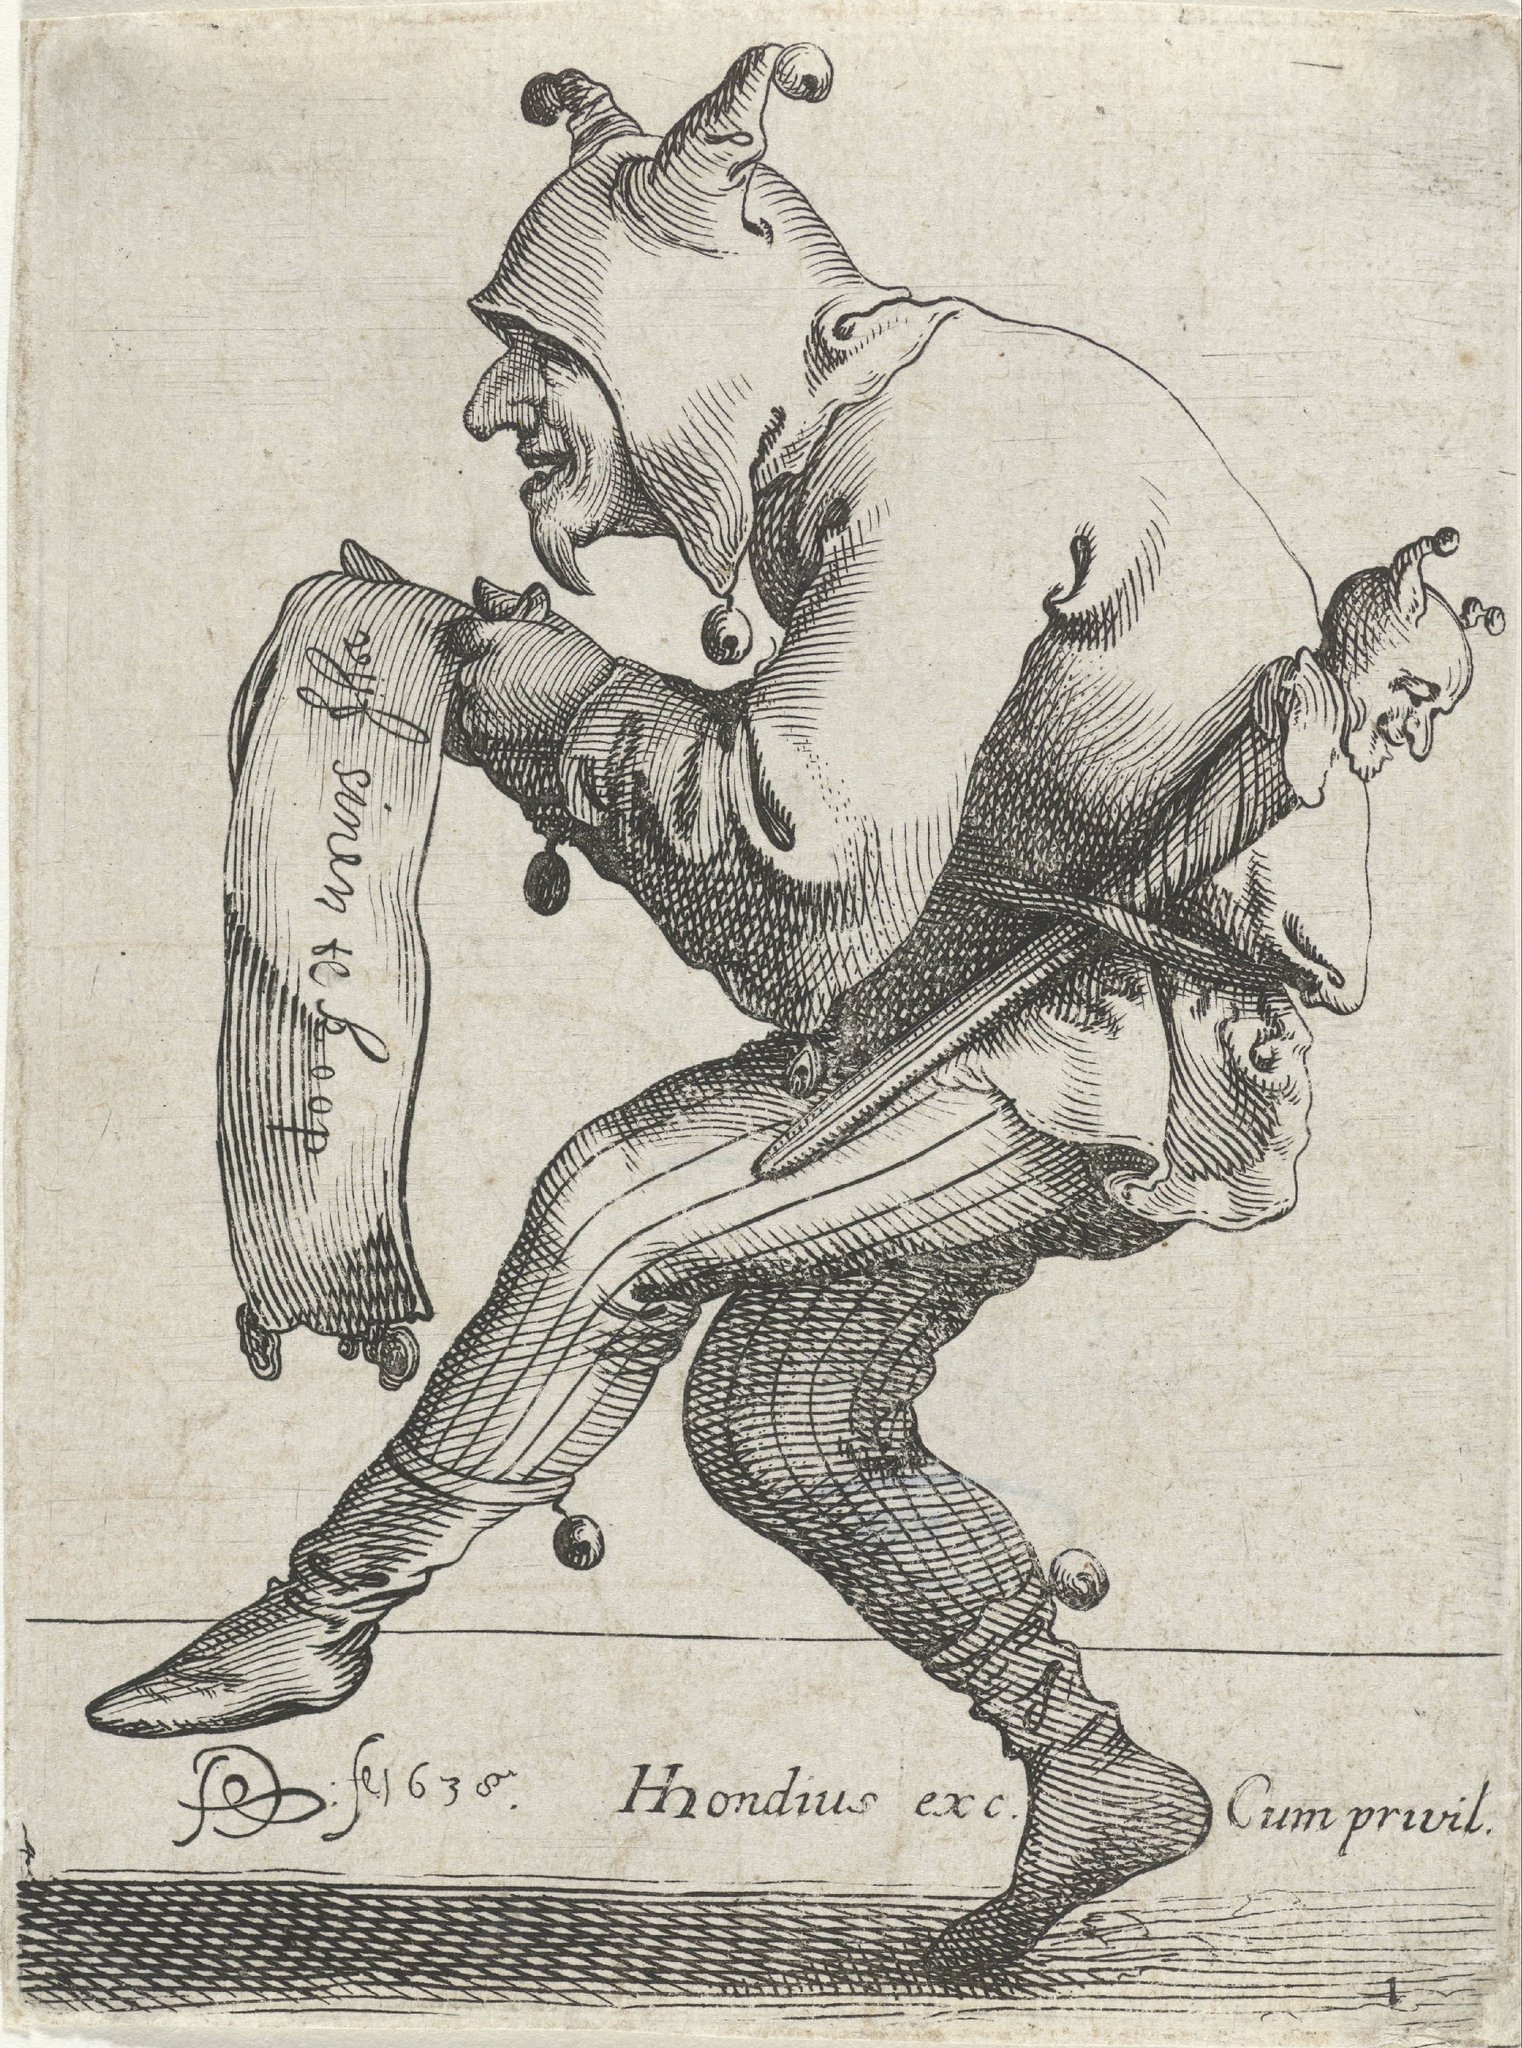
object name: titelprent, frontispice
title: De vijf zintuigen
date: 1638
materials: paper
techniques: engraving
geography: the hague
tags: court jester, court fool, the (five) senses, title-page, attributes of court jester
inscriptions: collector's mark: Lugt 2228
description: Een op zijn tenen lopende nar houdt een stuk papier vast met daarop de serietitel van de reeks prenten. Onder de riem van de nar zit een marot geklemd. De prent maakt deel uit van een serie van zes prenten met de vijf zintuigen.